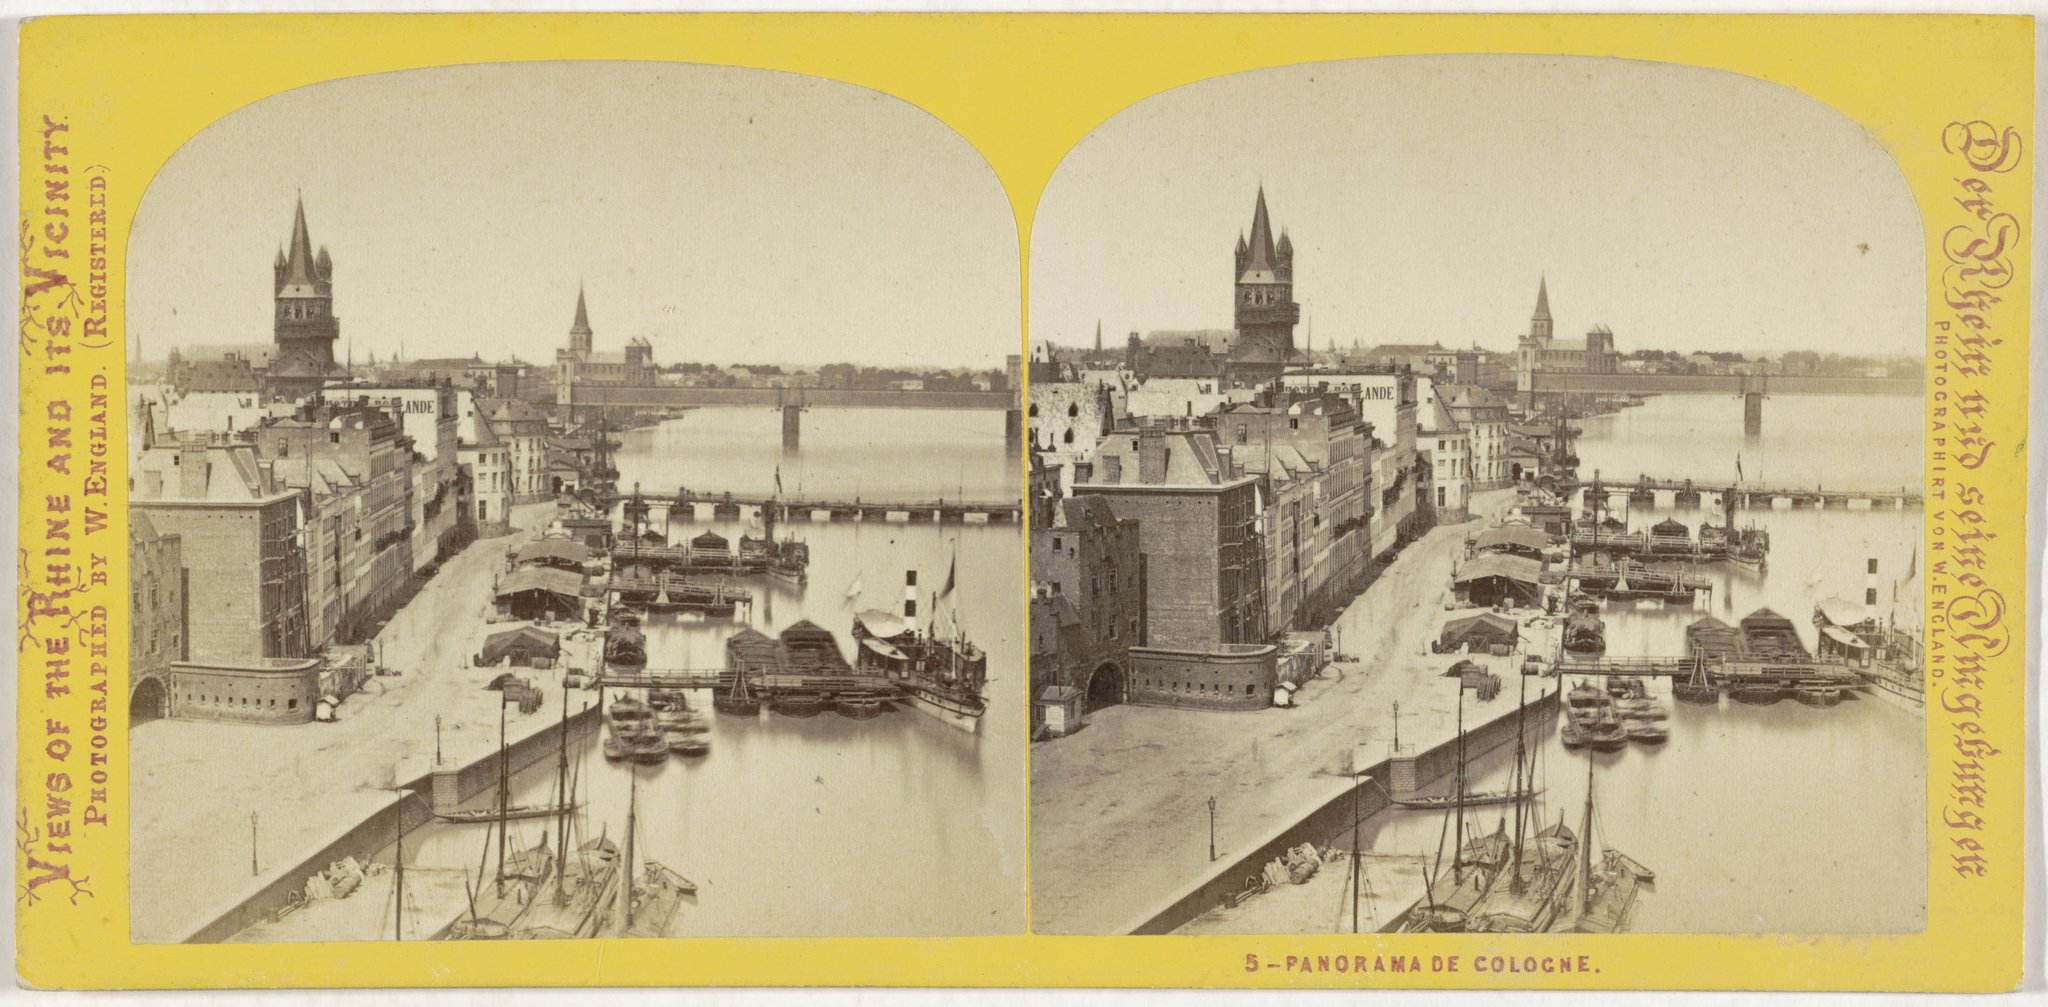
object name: stereograph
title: Gezicht op Keulen en de Rijn, Duitsland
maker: william england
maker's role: fotograaf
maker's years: 1816-1896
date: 1867-1868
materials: cardboard, paper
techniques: albumen print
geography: cologne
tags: river, prospect of city, town panorama, silhouette of city, quay, cologne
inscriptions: inscription: ‘(Registered)’, number: ‘5’